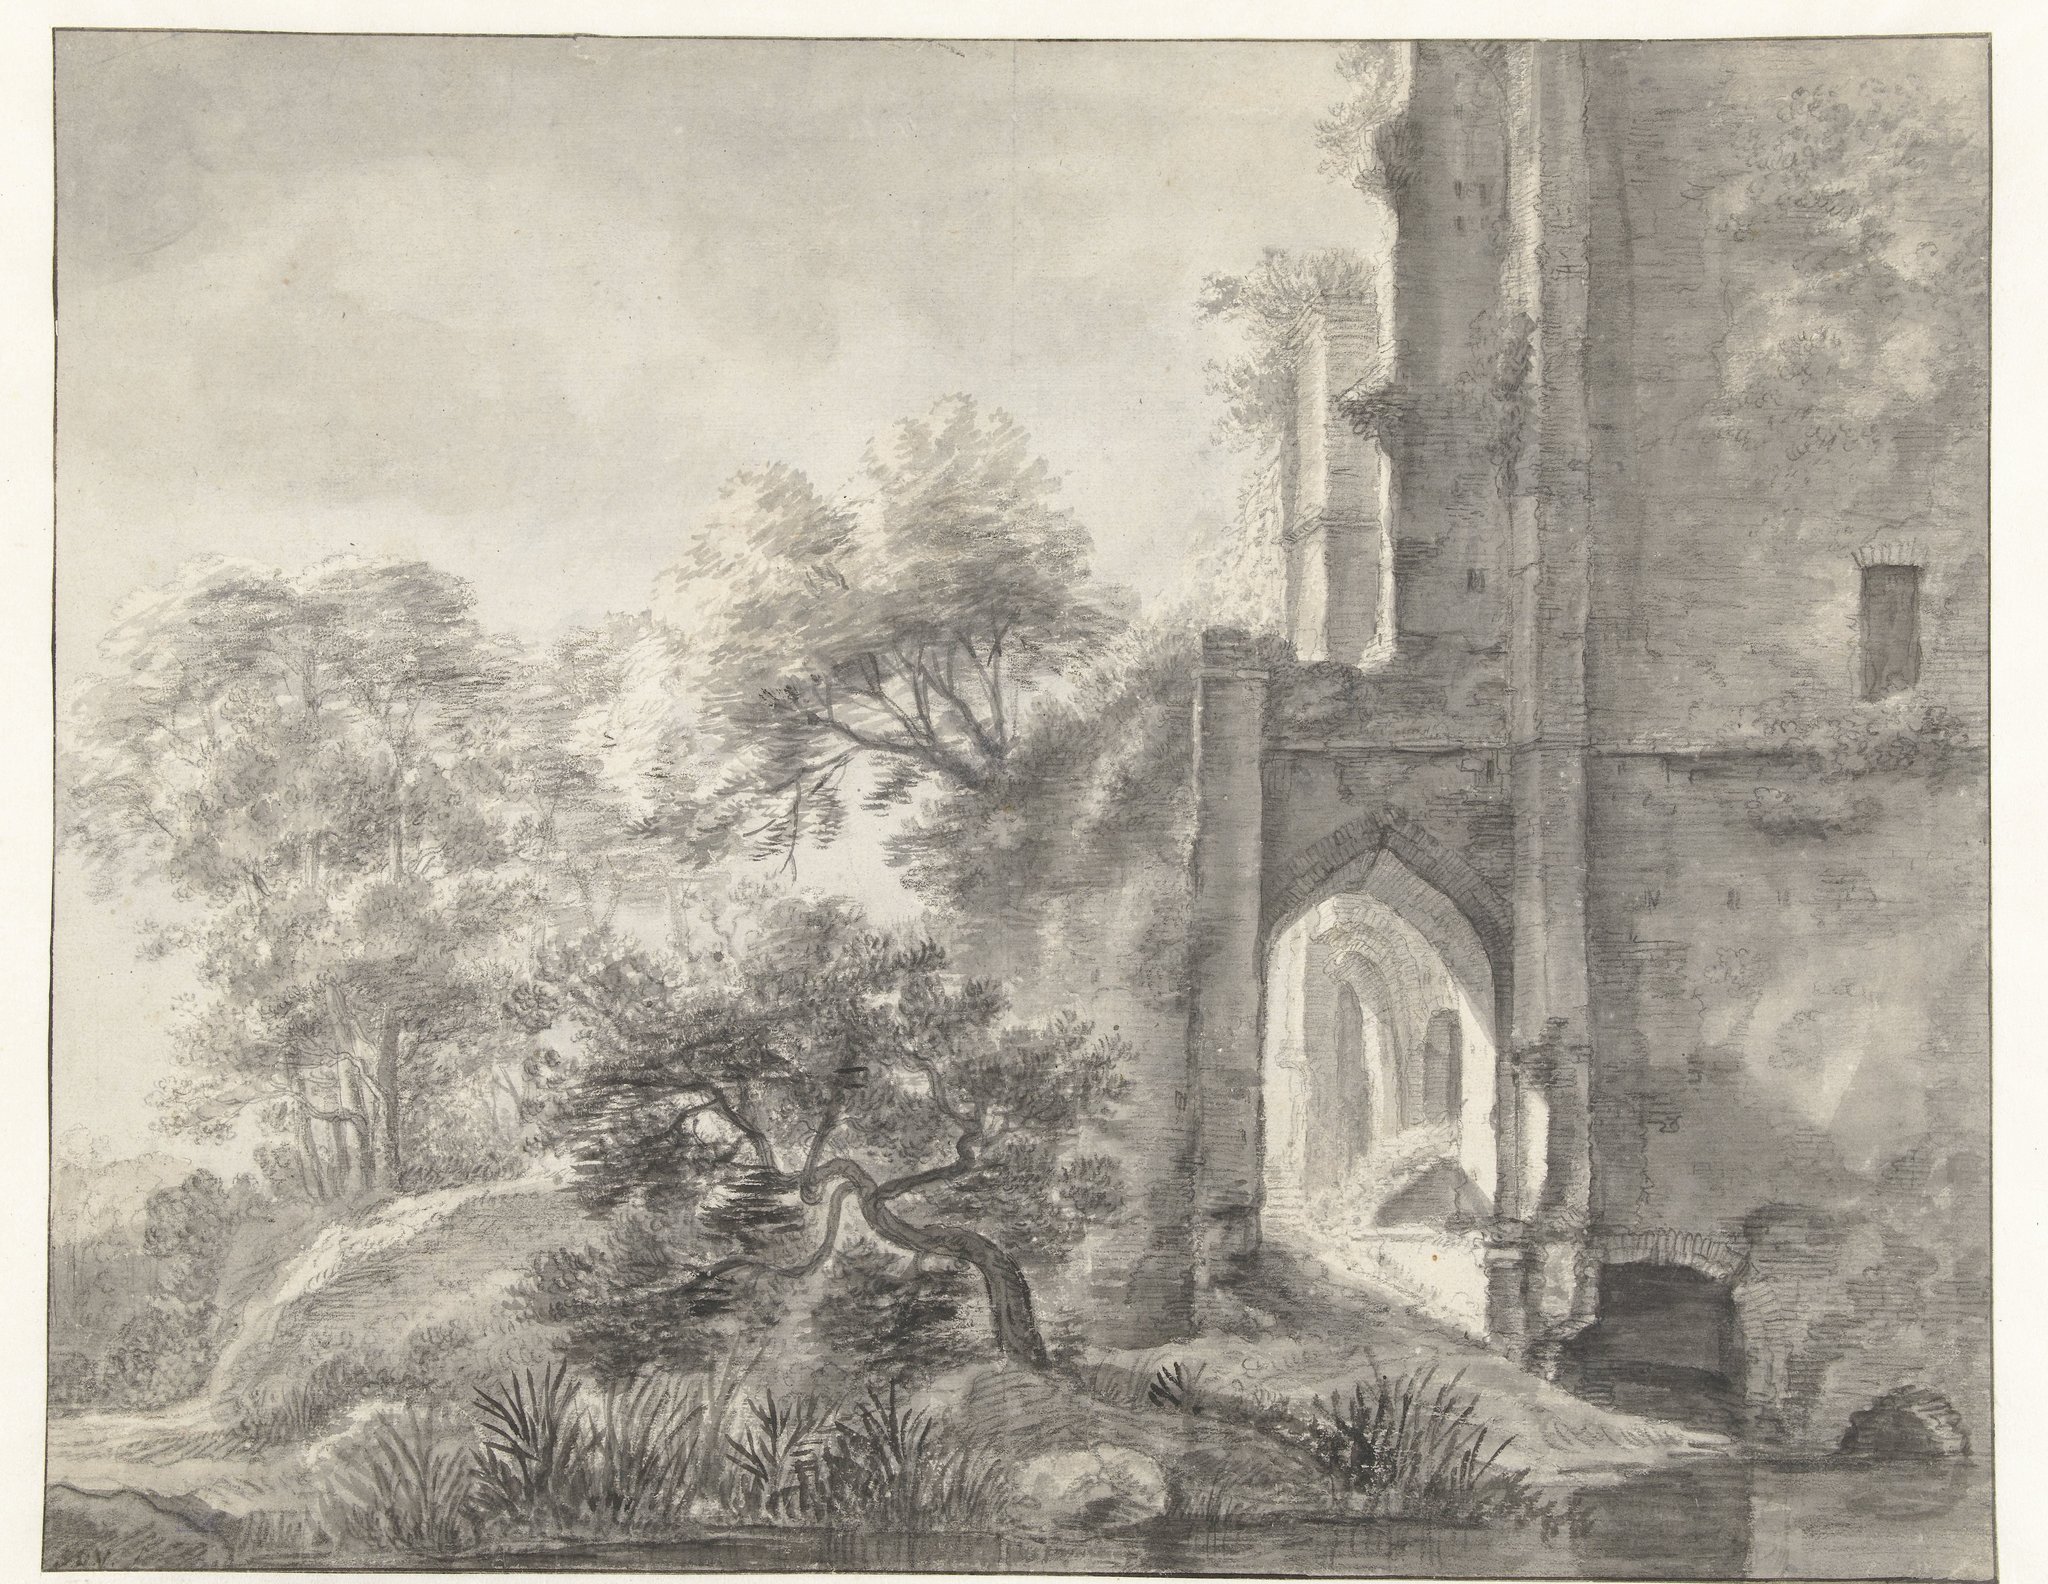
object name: drawing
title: Ruïne van Brederode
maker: simon de vlieger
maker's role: draughtsman, painter, print maker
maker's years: 1600-1653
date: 1610-1653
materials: chalk, paper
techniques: brush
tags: castle, ruin of a building ~ architecture